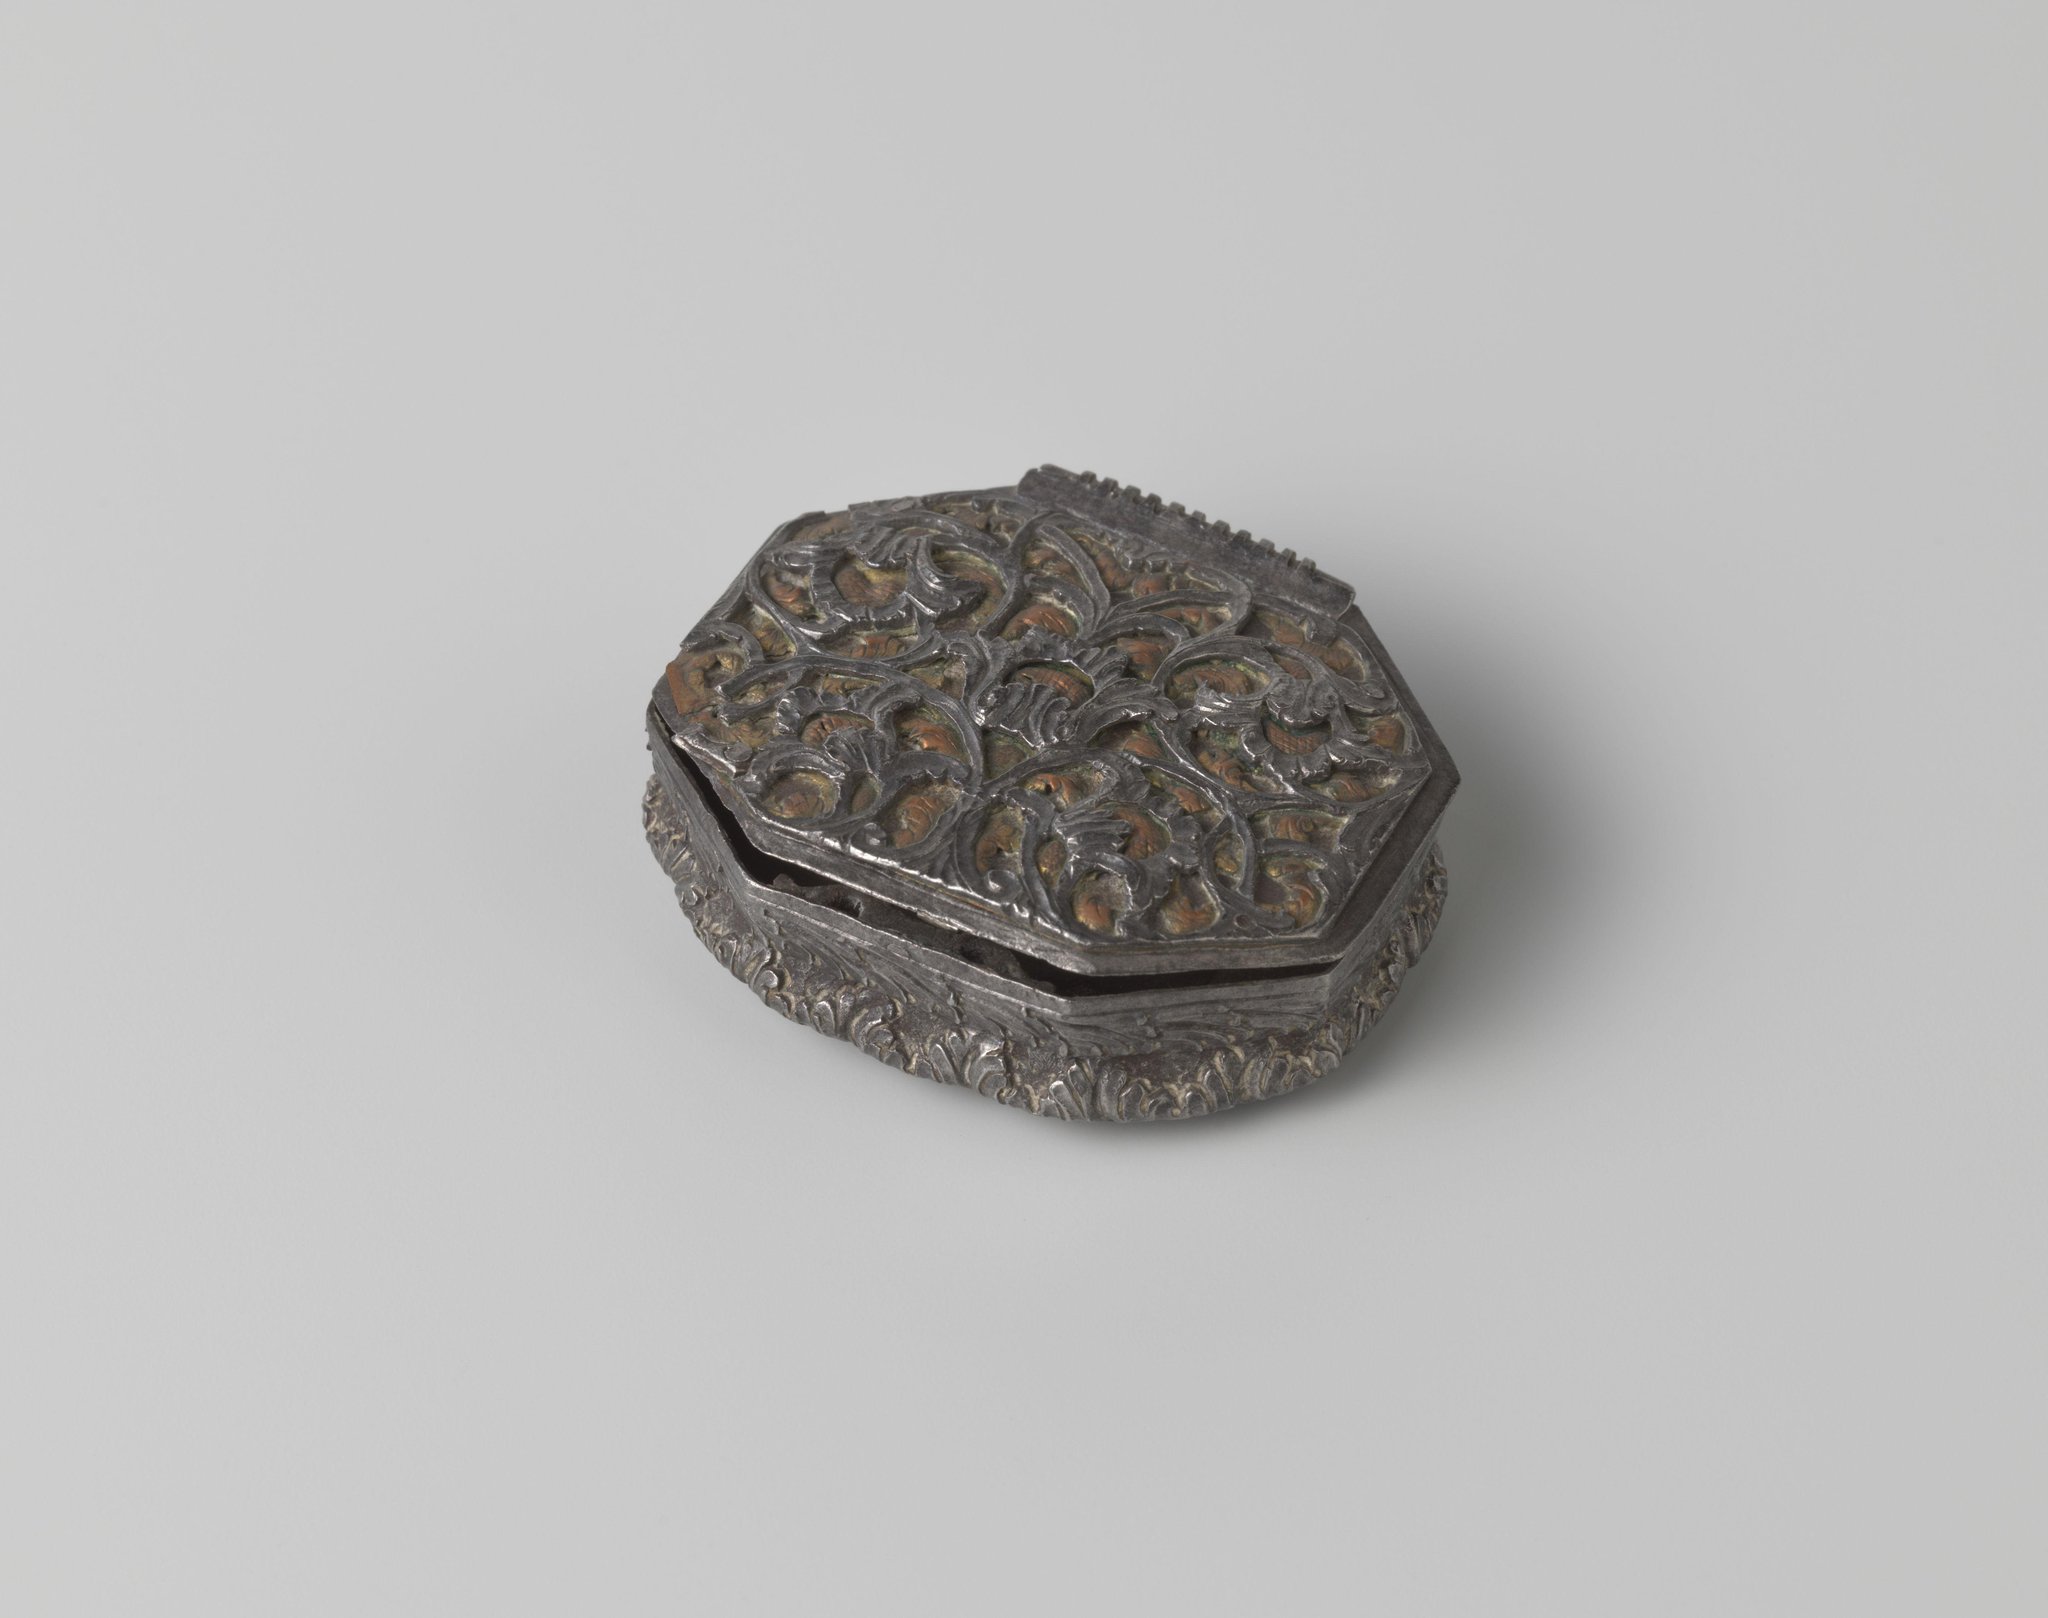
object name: suikerdoos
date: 1600-1699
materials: copper, iron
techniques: metalworking, forging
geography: france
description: Een achtkantige suikerdoos van gesmeed ijzer met een ajour bewerkte versiering van bladeren en bloemen op een ondergrond van rood koper op het deksel en geciseleerd bladwerk aan de zijden. .